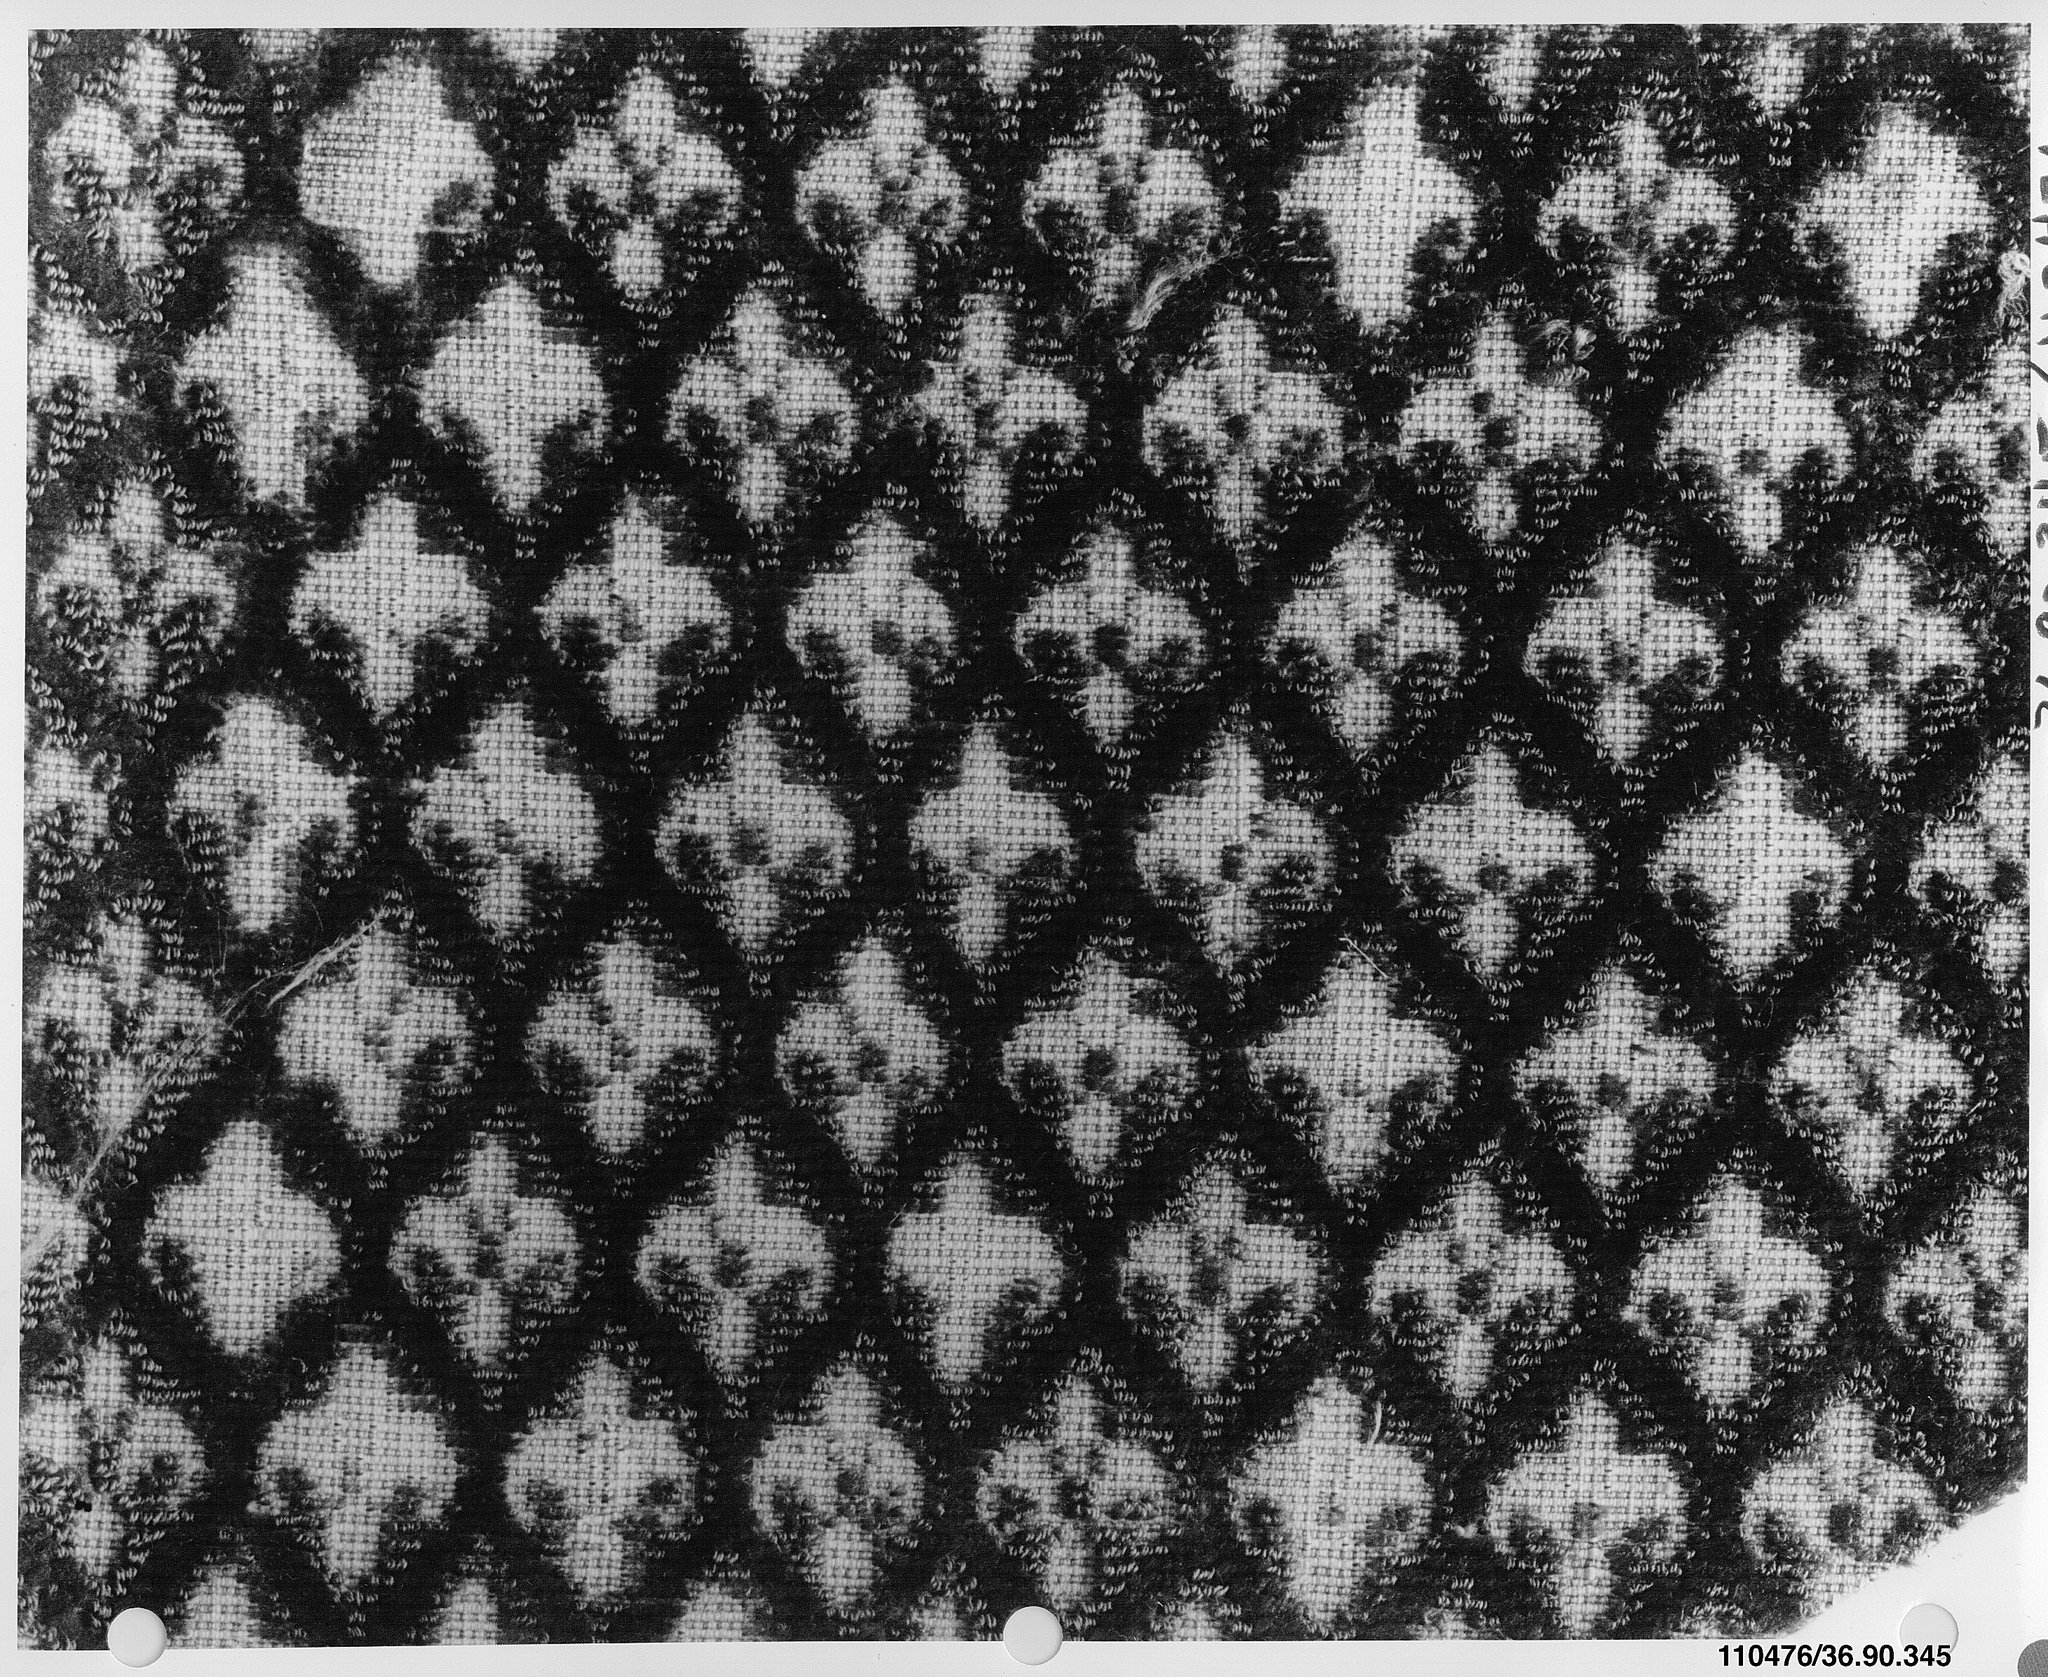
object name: piece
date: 1501-1700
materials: silk